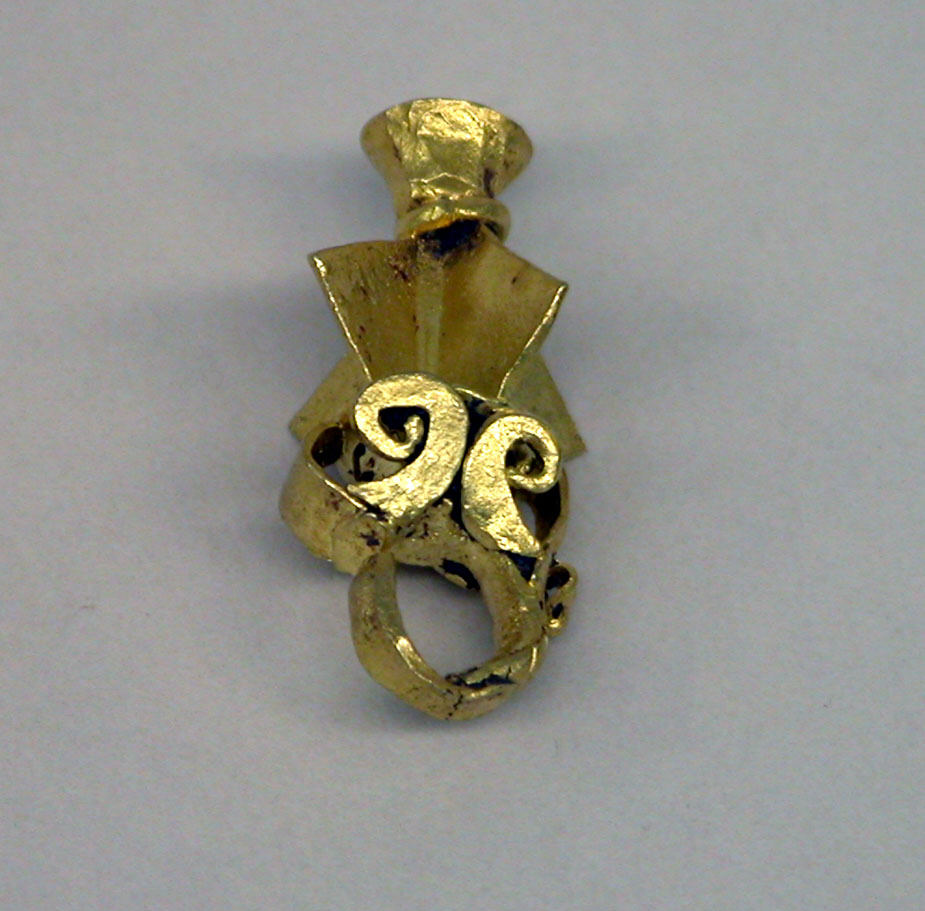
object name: pendant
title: Diamond-Shaped Pendant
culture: indonesian, javanese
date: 1801-2000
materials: gold